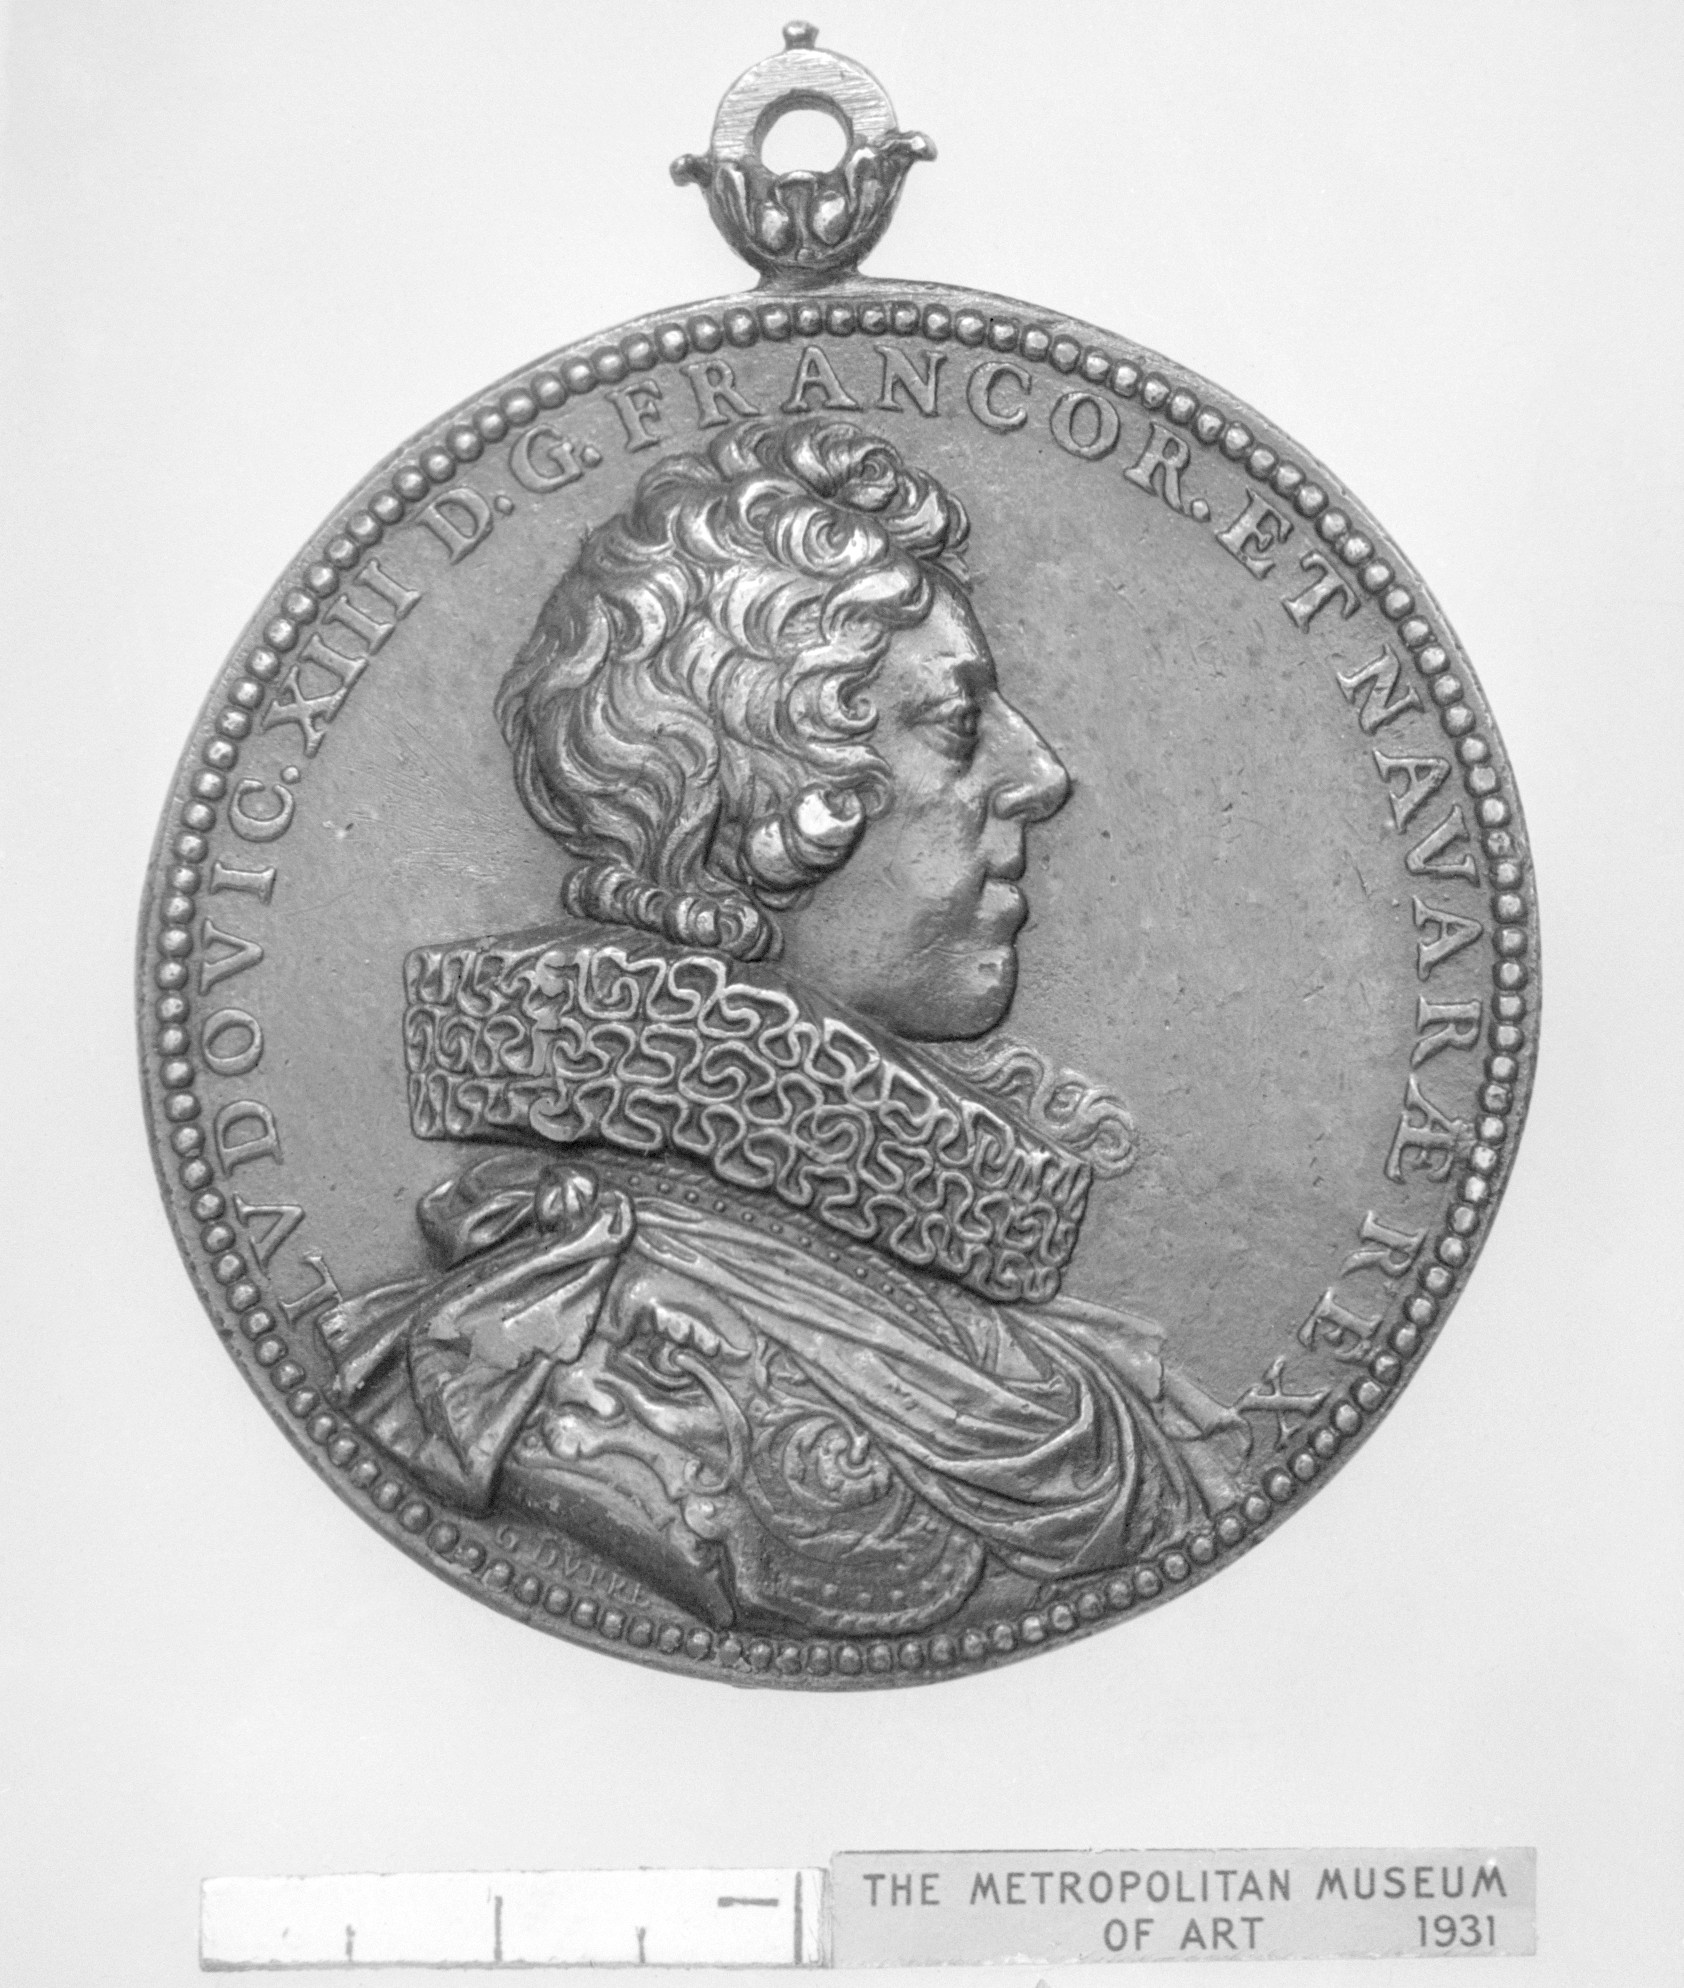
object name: medal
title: Louis XIII, King of France (b. 1601, r. 1610–43)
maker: guillaume dupré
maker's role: artist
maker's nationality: french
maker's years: 1579-1640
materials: bronze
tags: kings,men,portraits,profiles,women